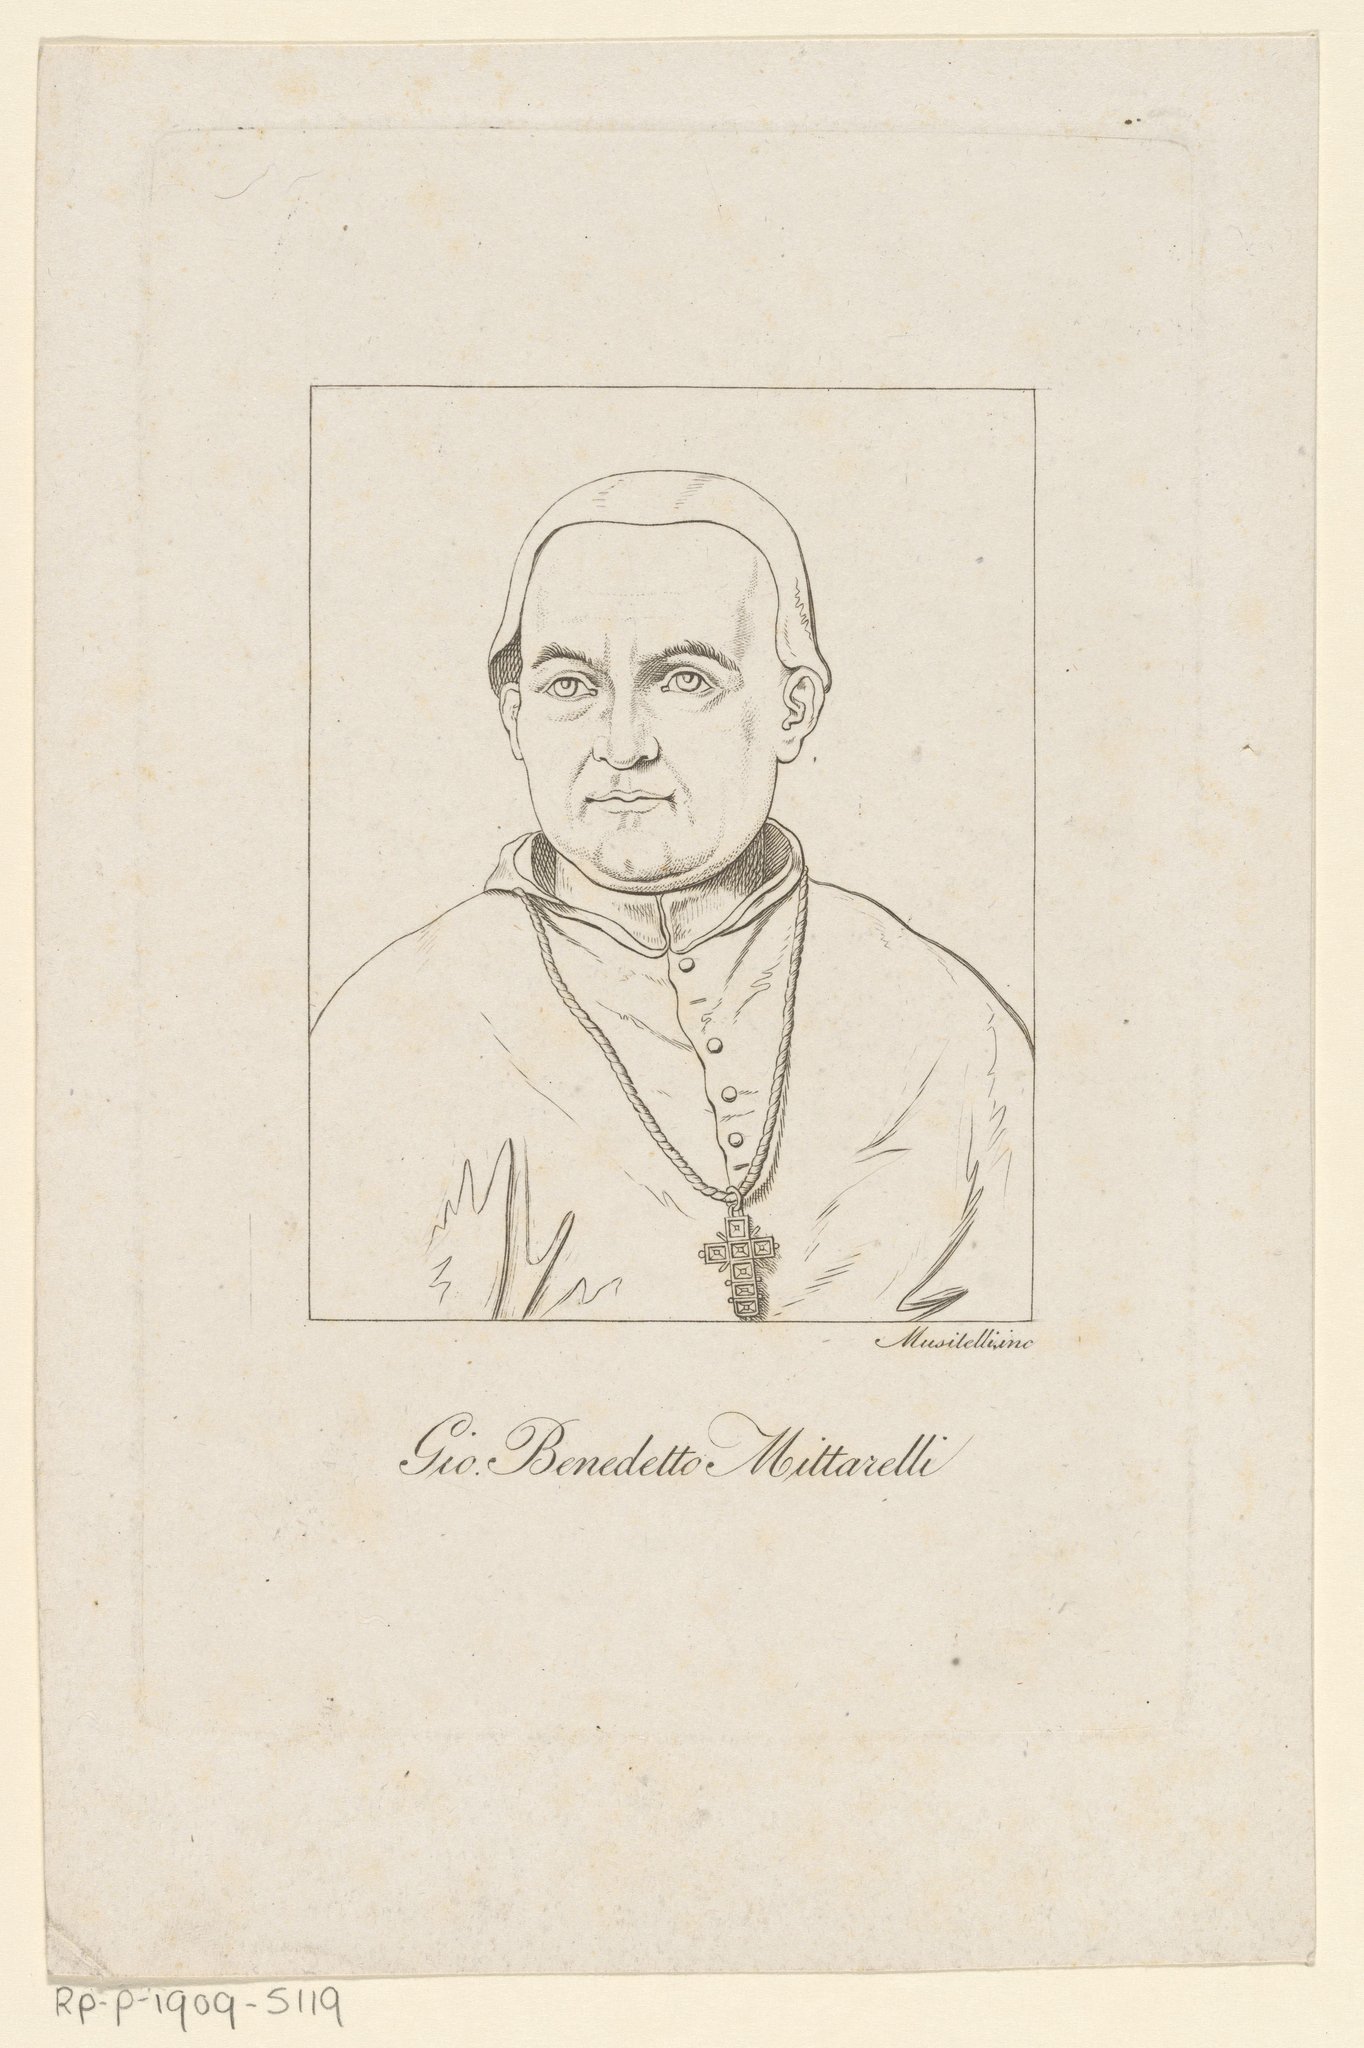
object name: print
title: Portret van monnik Giovanni Benedetto Mittarelli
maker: benedetto musitelli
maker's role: print maker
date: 1813-1818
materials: paper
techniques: etching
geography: italy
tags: venice, historical persons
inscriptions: collector's mark: Lugt 2228